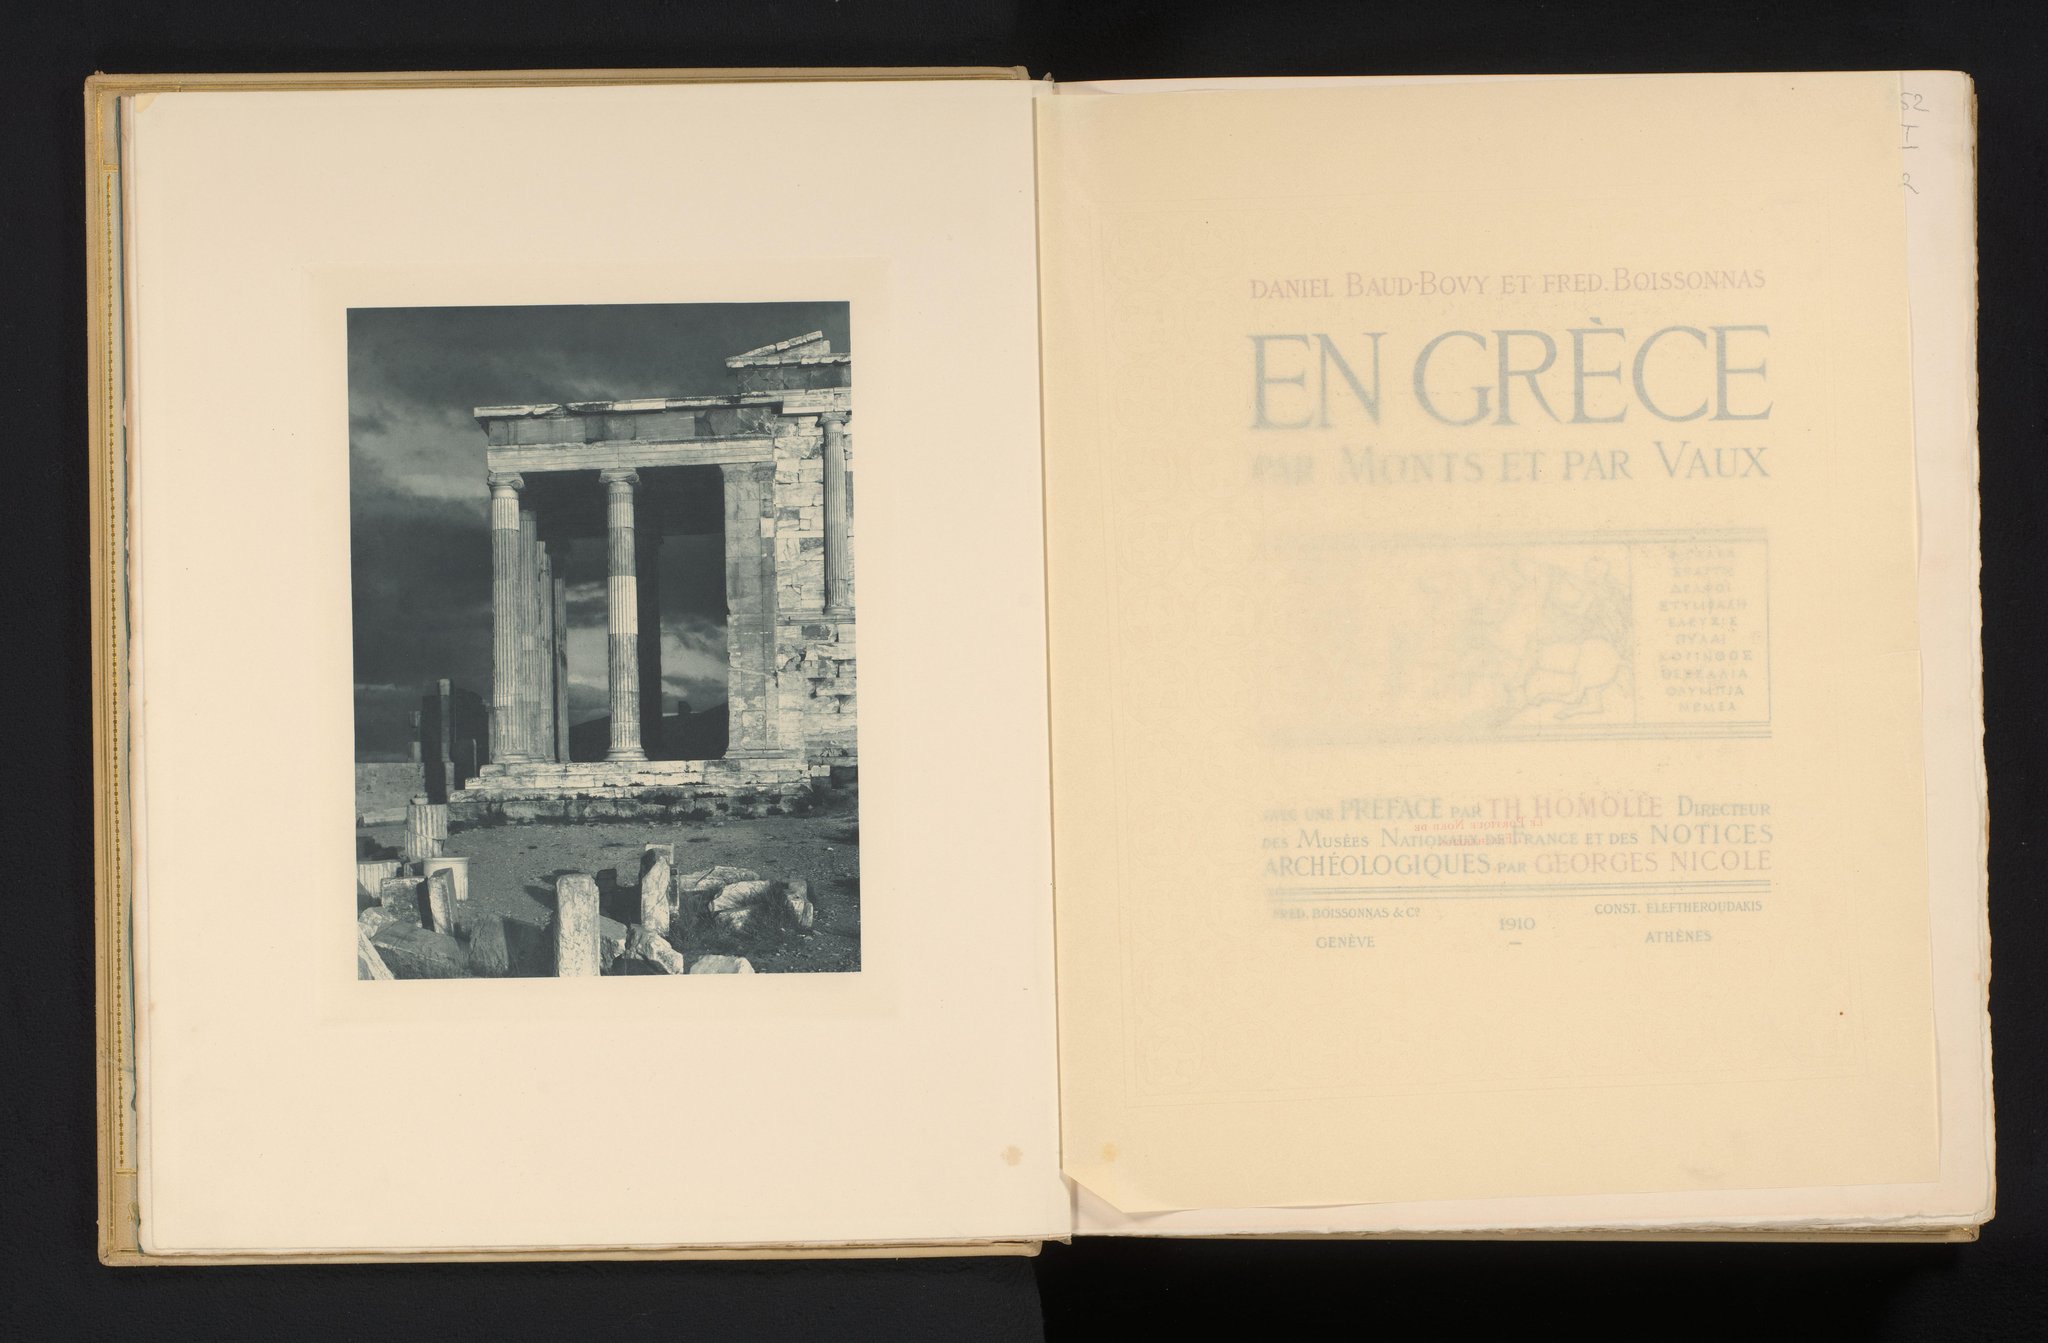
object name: page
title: Le portique nord de l'Erechtheion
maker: frédéric boissonnas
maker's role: fotograaf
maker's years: 1858-1946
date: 1905-1910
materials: paper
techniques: photoaquatint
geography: berlin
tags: temple, shrine ~ roman religion